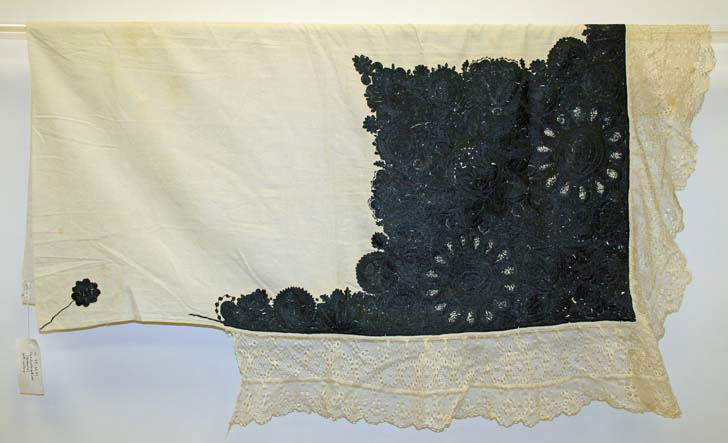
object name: headcloth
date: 1701-1800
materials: linen, silk